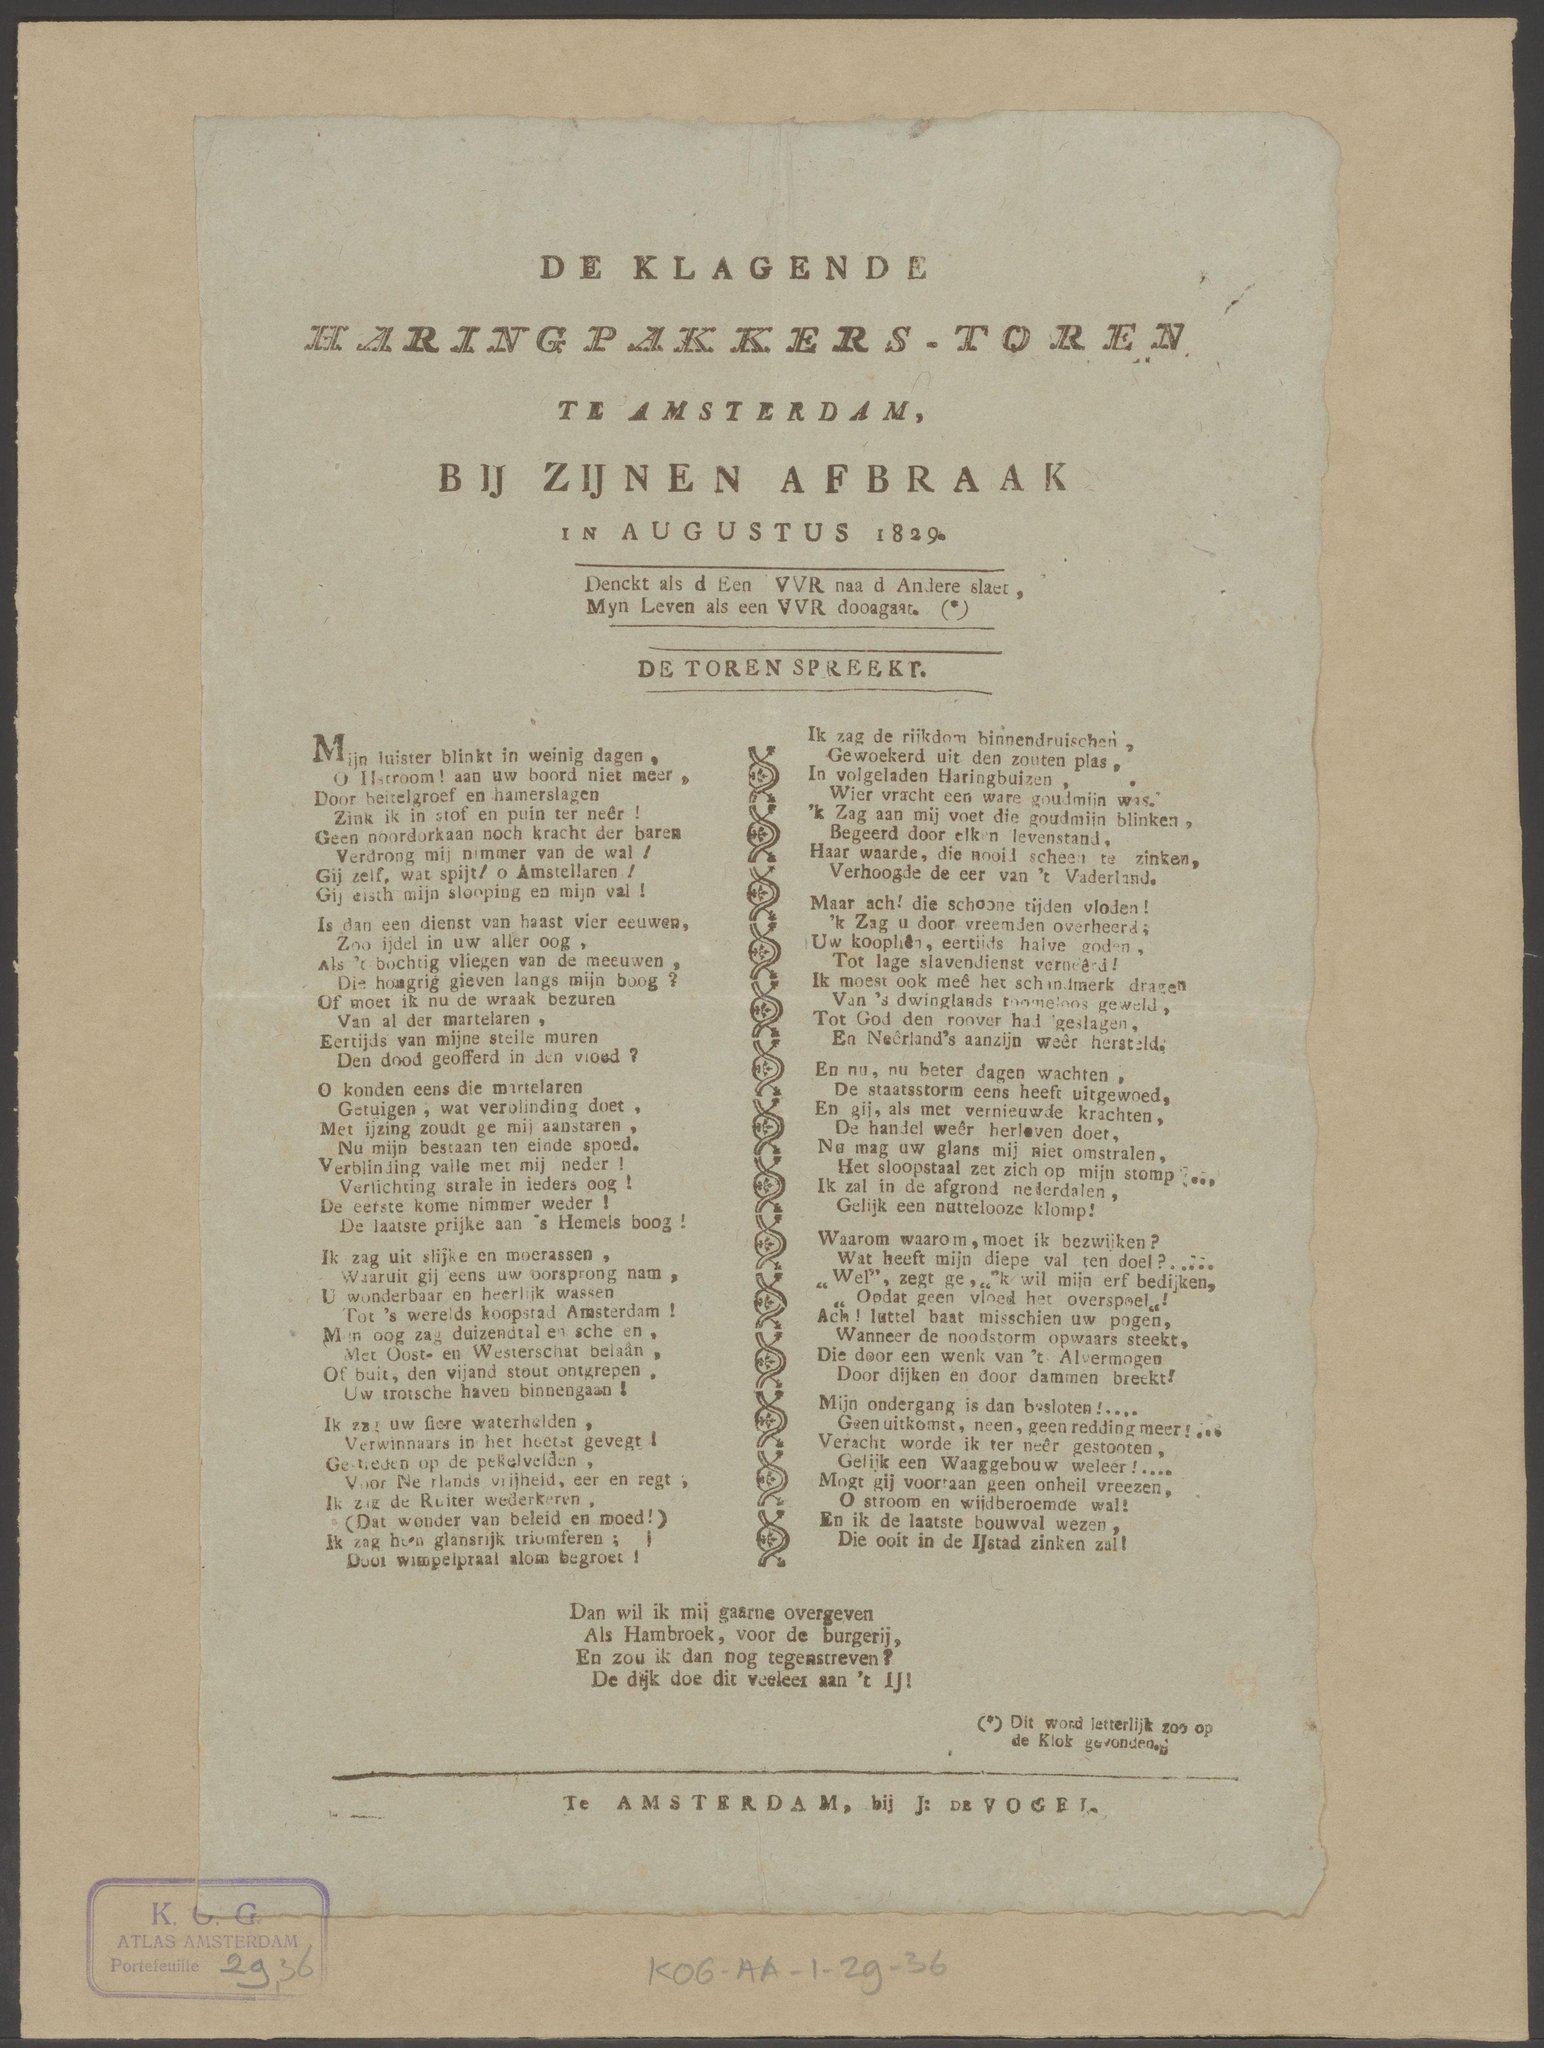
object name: text sheet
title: Vers op het afbreken van de Haringpakkerstoren te Amsterdam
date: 1829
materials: paper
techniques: letterpress printing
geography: amsterdam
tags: tower, clock tower ~ monumental adornment, demolition of building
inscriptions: collector's mark: Lugt 1641b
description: Onderwerpsrubriek binnen de Atlas Amsterdam: Haringpakkerstoren.